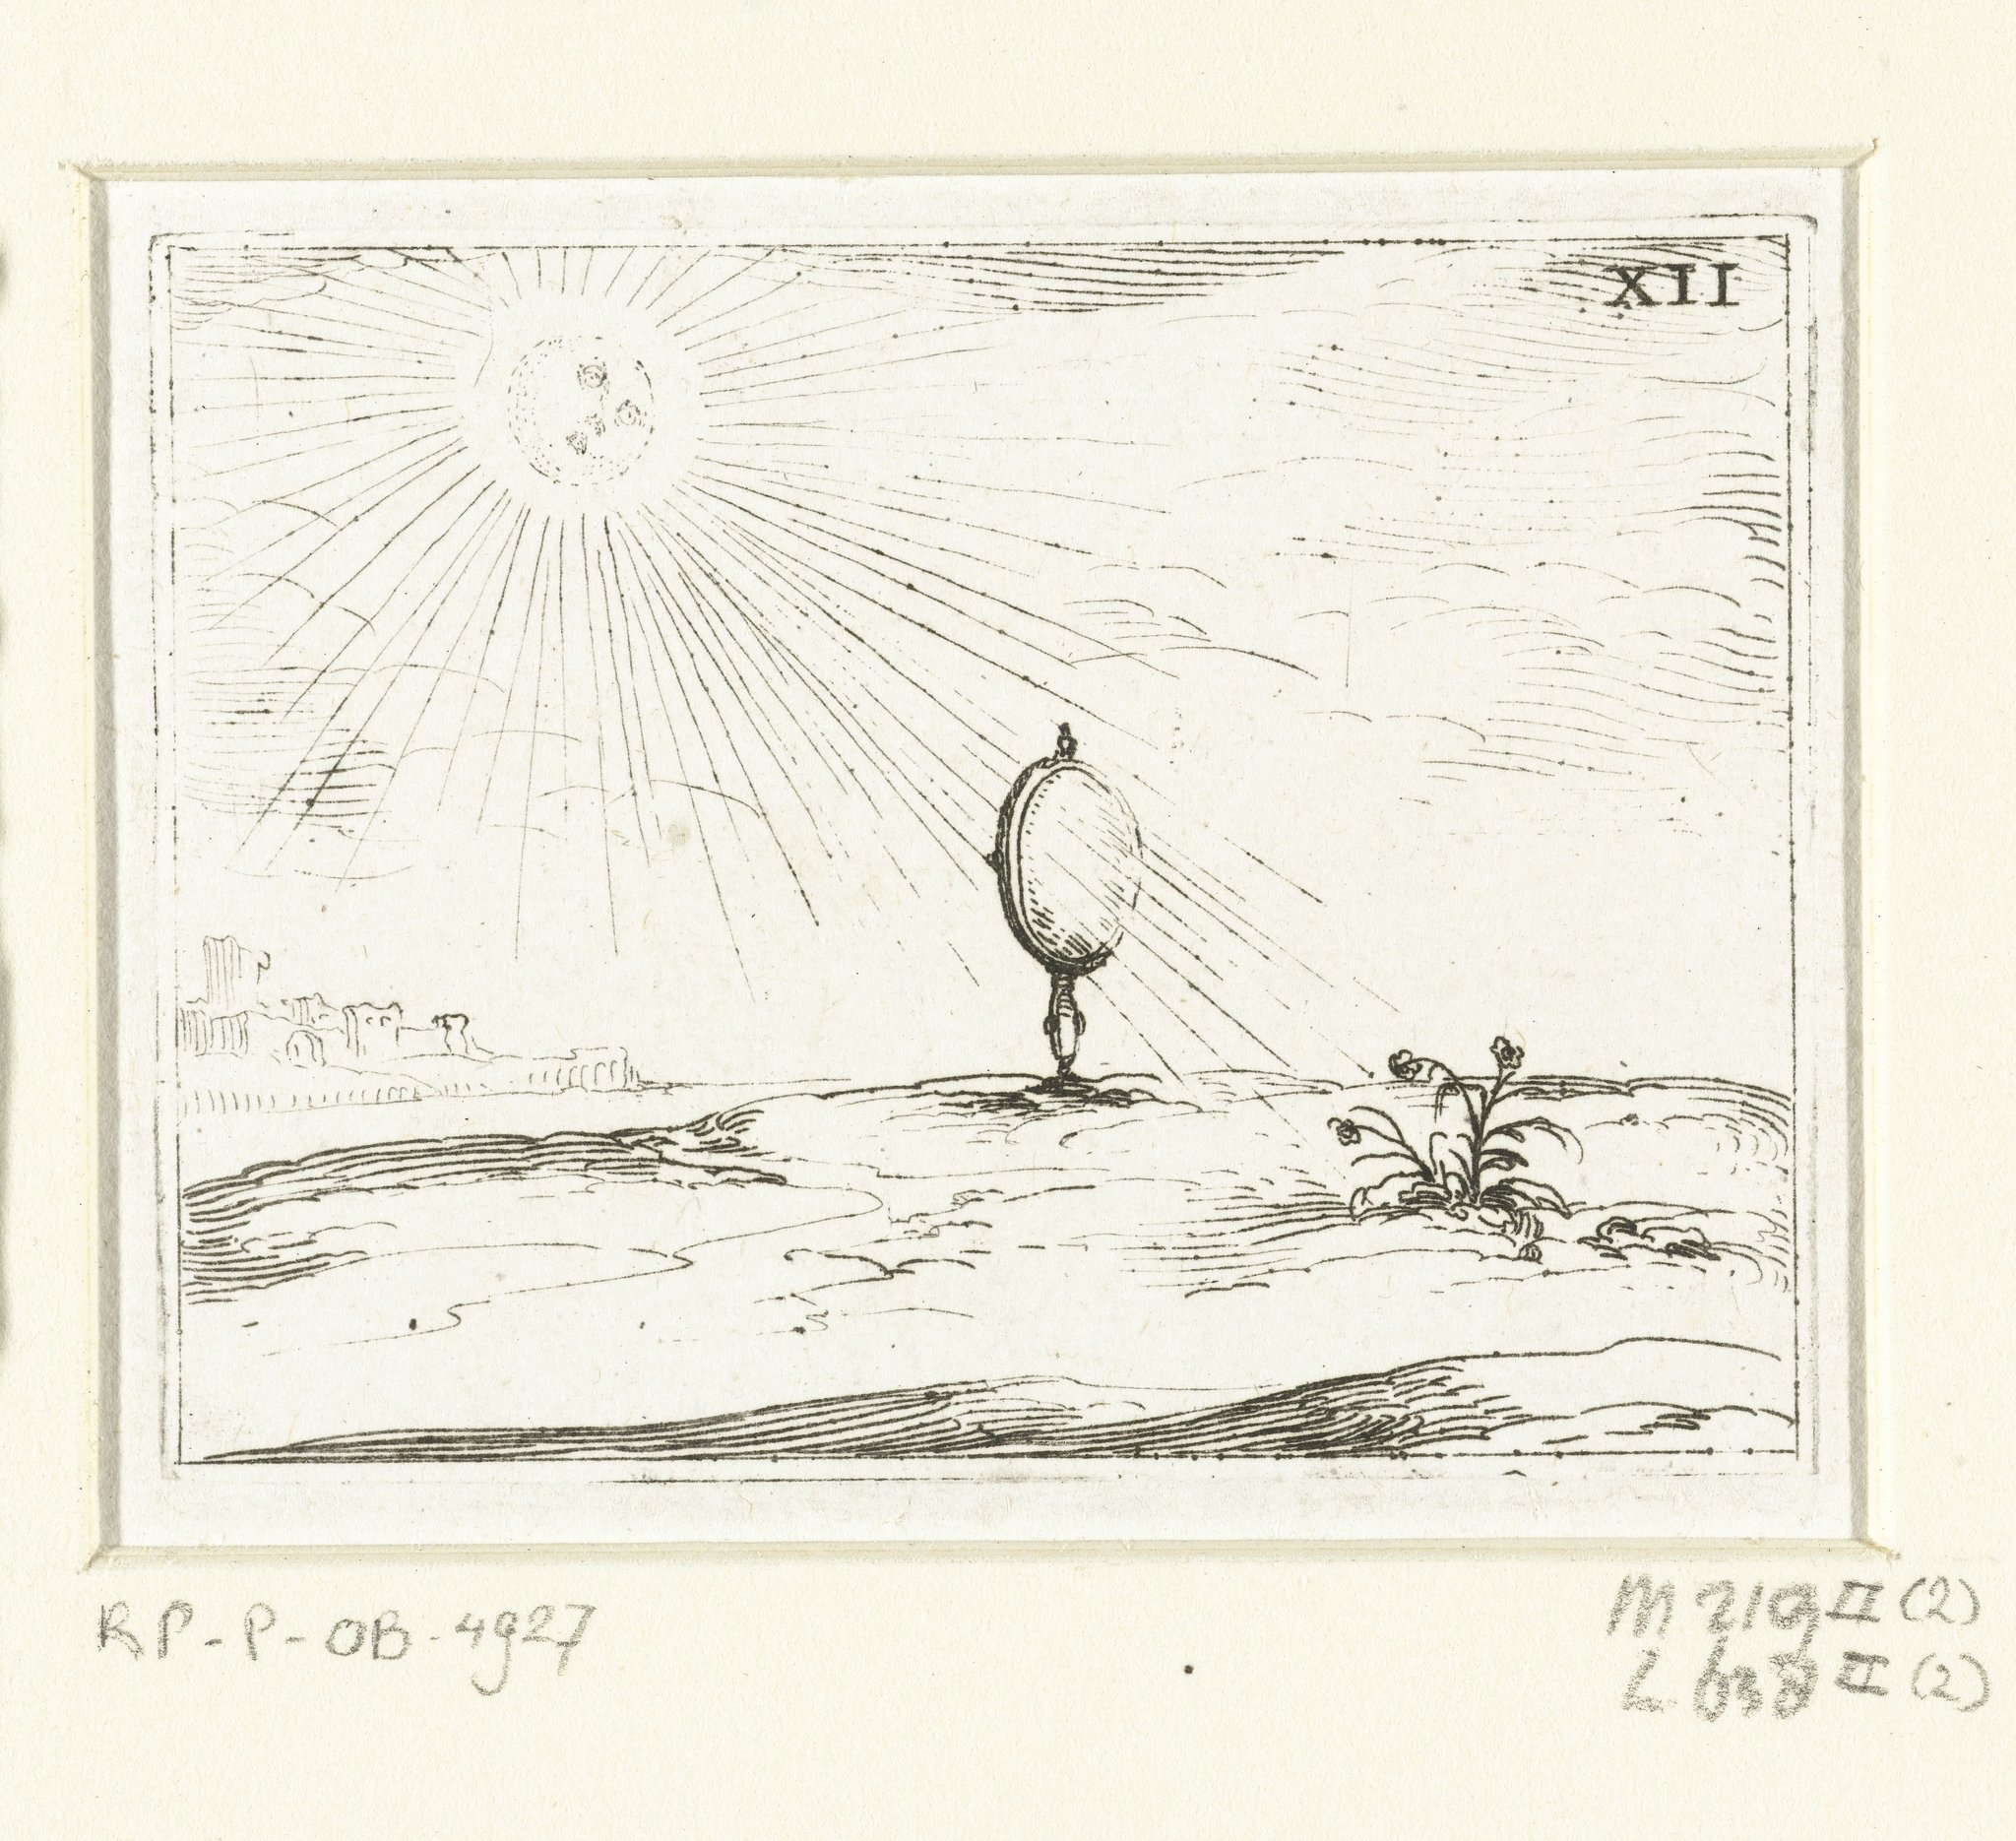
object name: cognizance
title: Zonnestralen schijnen door een glas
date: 1625-1629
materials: paper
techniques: etching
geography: nancy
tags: sunbeams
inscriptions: collector's mark: Lugt 240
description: Voorstelling van een glas of spiegel in ronde omlijsting, rechtop staand op de grond, waardoorheen zonnestralen schijnen. Dit blad is onderdeel van de embleemserie 'Leven van Maria in emblemen'. De eerste staat van deze serie behelst naast een titelpagina en 26 emblemen ook drie bladen met lofzangen op Maria in boekdruk zonder afbeelding.